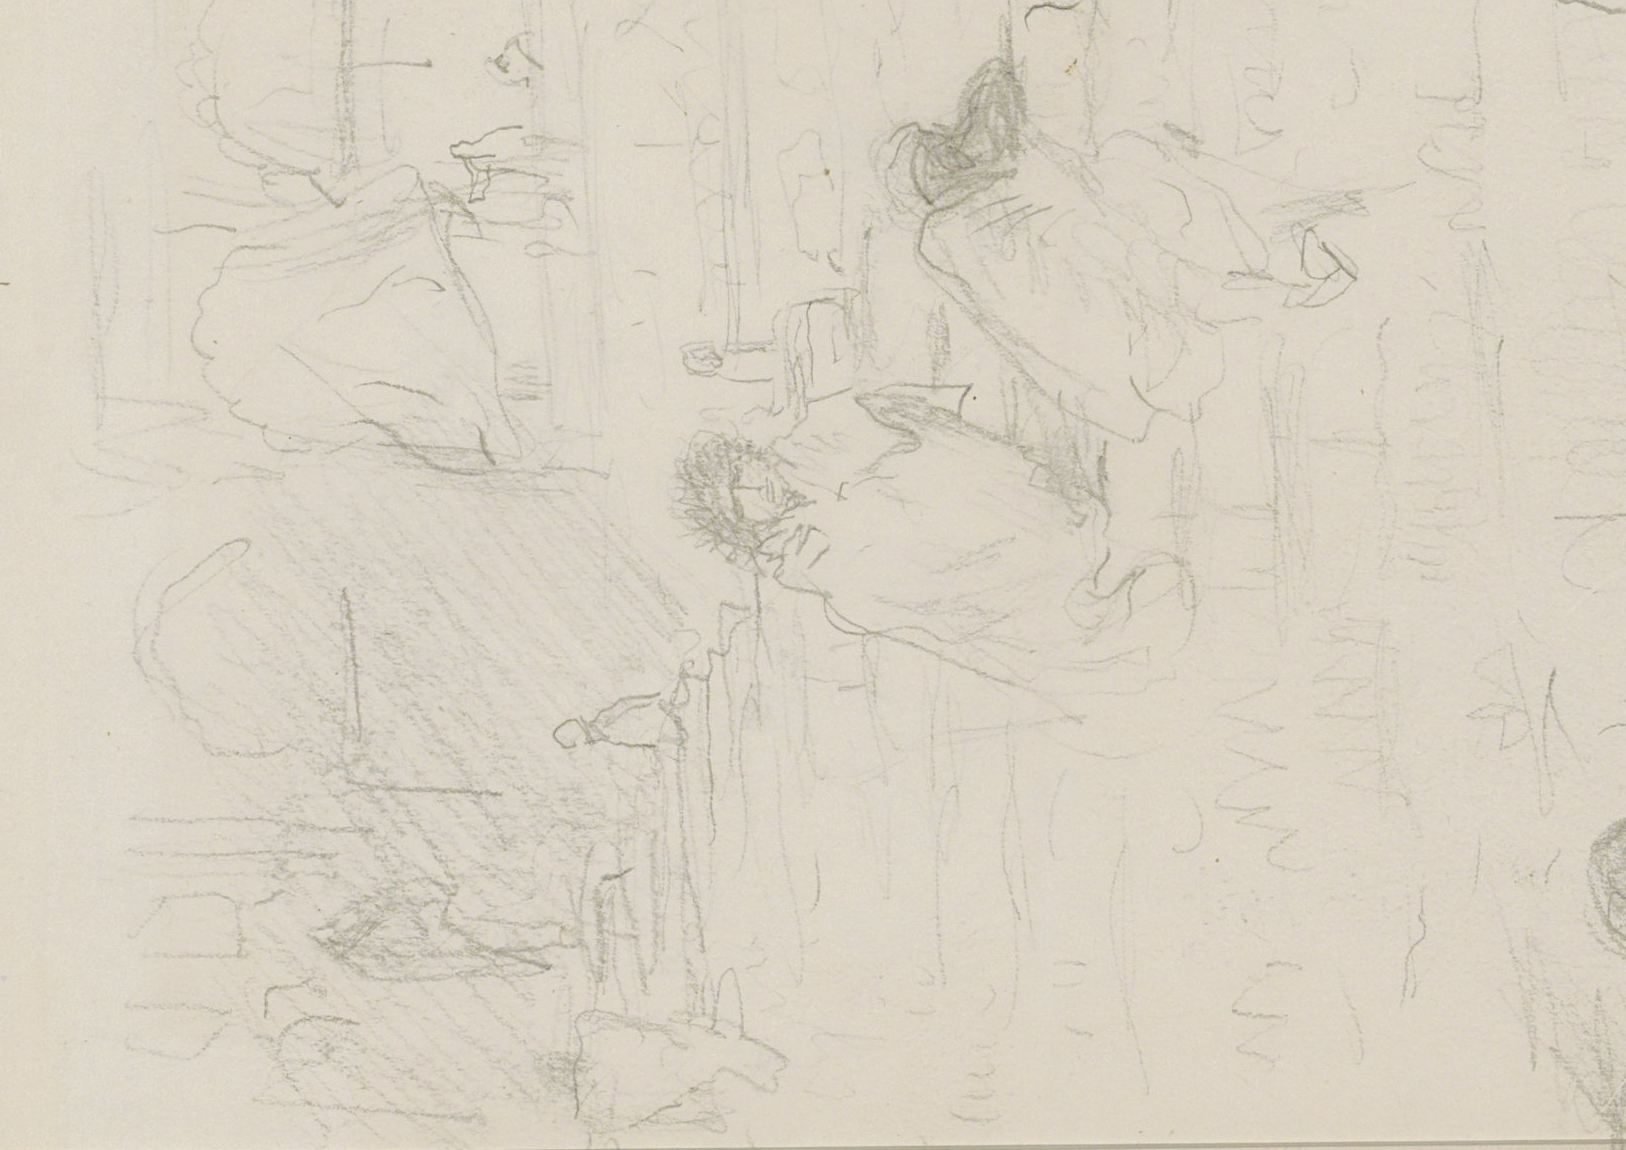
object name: sketchbook leaf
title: Indiërs op een trap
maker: marius bauer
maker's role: draughtsman, print maker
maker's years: 1867-1932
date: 1925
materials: paper, pencil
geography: india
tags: flight of steps, asiatic races and peoples: indians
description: Vermoedelijk een deel van de trap die uitkomt op de rivier de Ganges. Pagina 1 uit een schetsboek met 15 bladen.